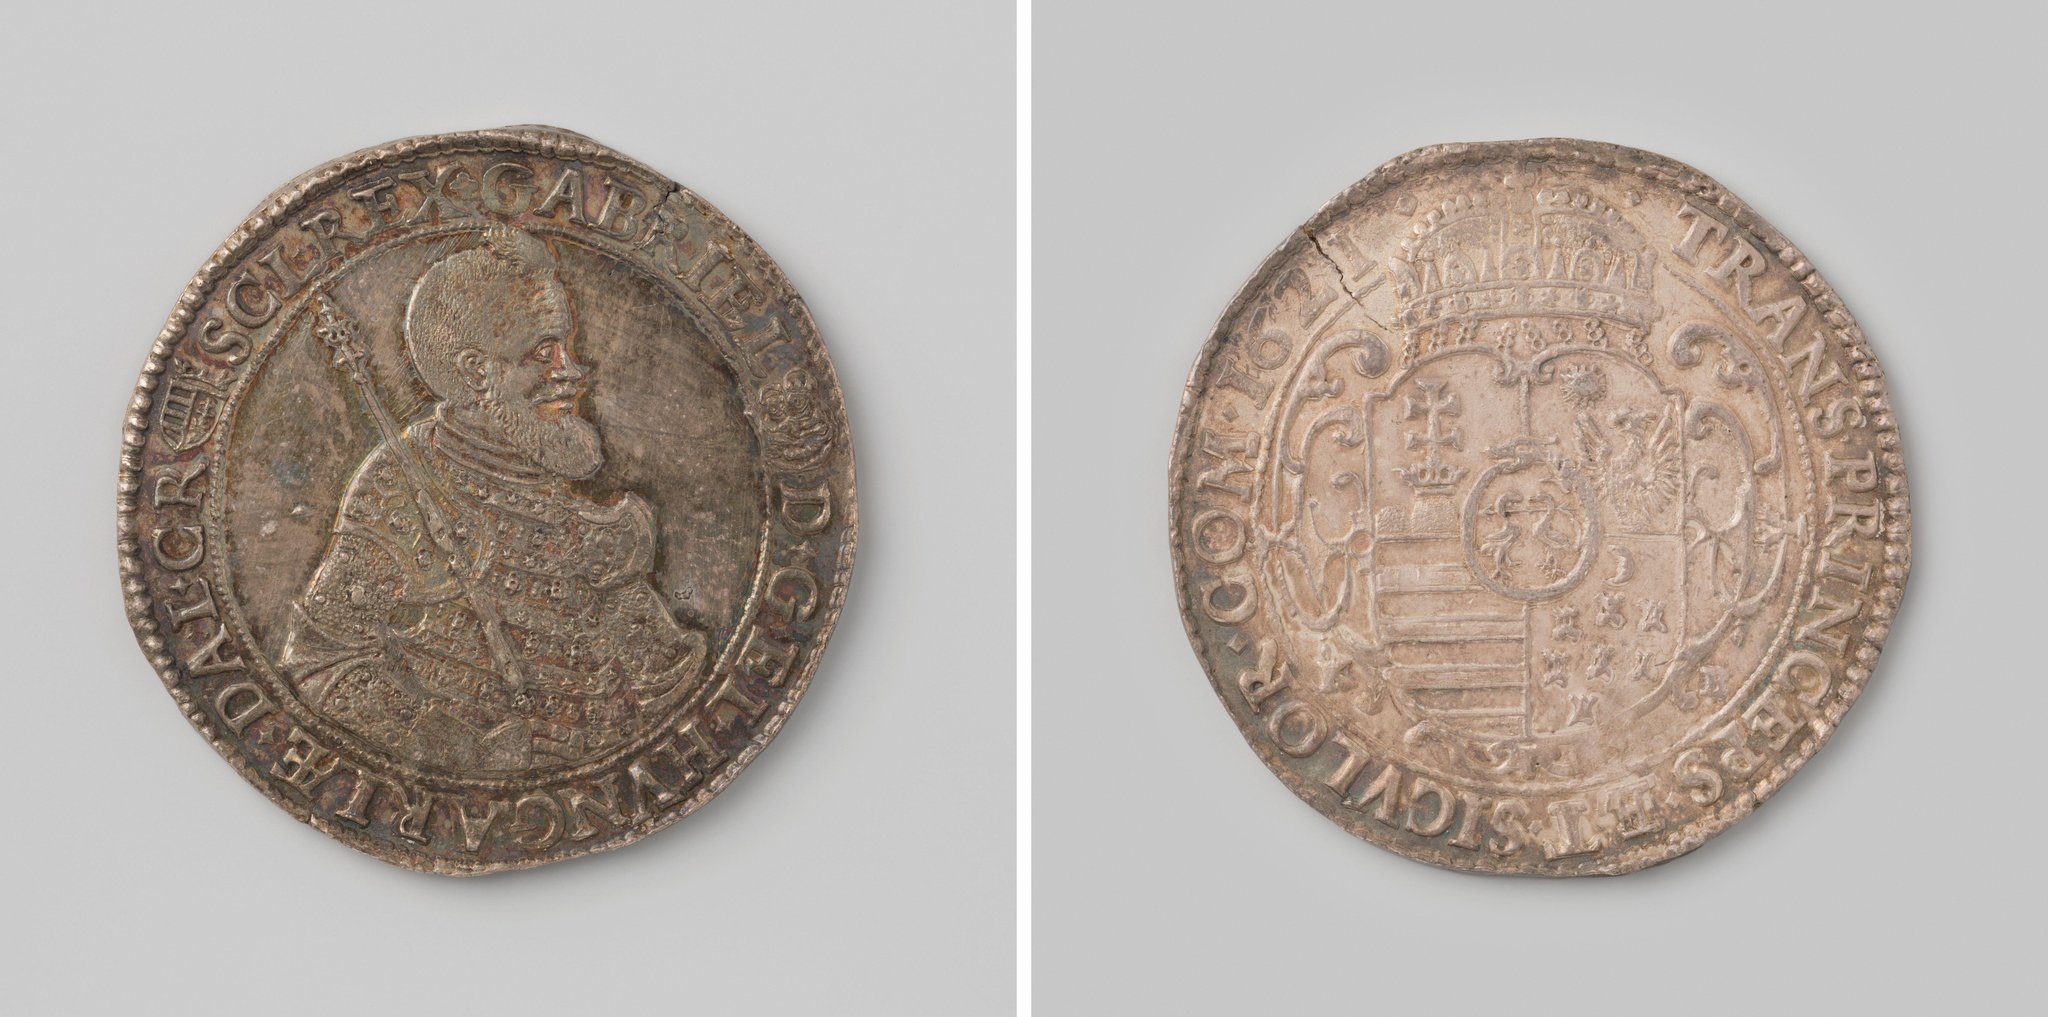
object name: coin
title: Vorstendom Transsylvanië (Zevenbergen), Gabriël Bethlen, taler,1621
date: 1621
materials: silver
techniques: striking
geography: kremnica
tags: prins, gabriël bethlen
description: Zilveren munt. Voorzijde: tussen twee wapenschilden geharnast borstbeeld van de vorst naar rechts met in rechterhand scepter. Keerzijde: tussen letters K en B [=Kremnitz] versierd gekroond samengesteld wapenschild. Jaartal aan het eind van het omschrift.